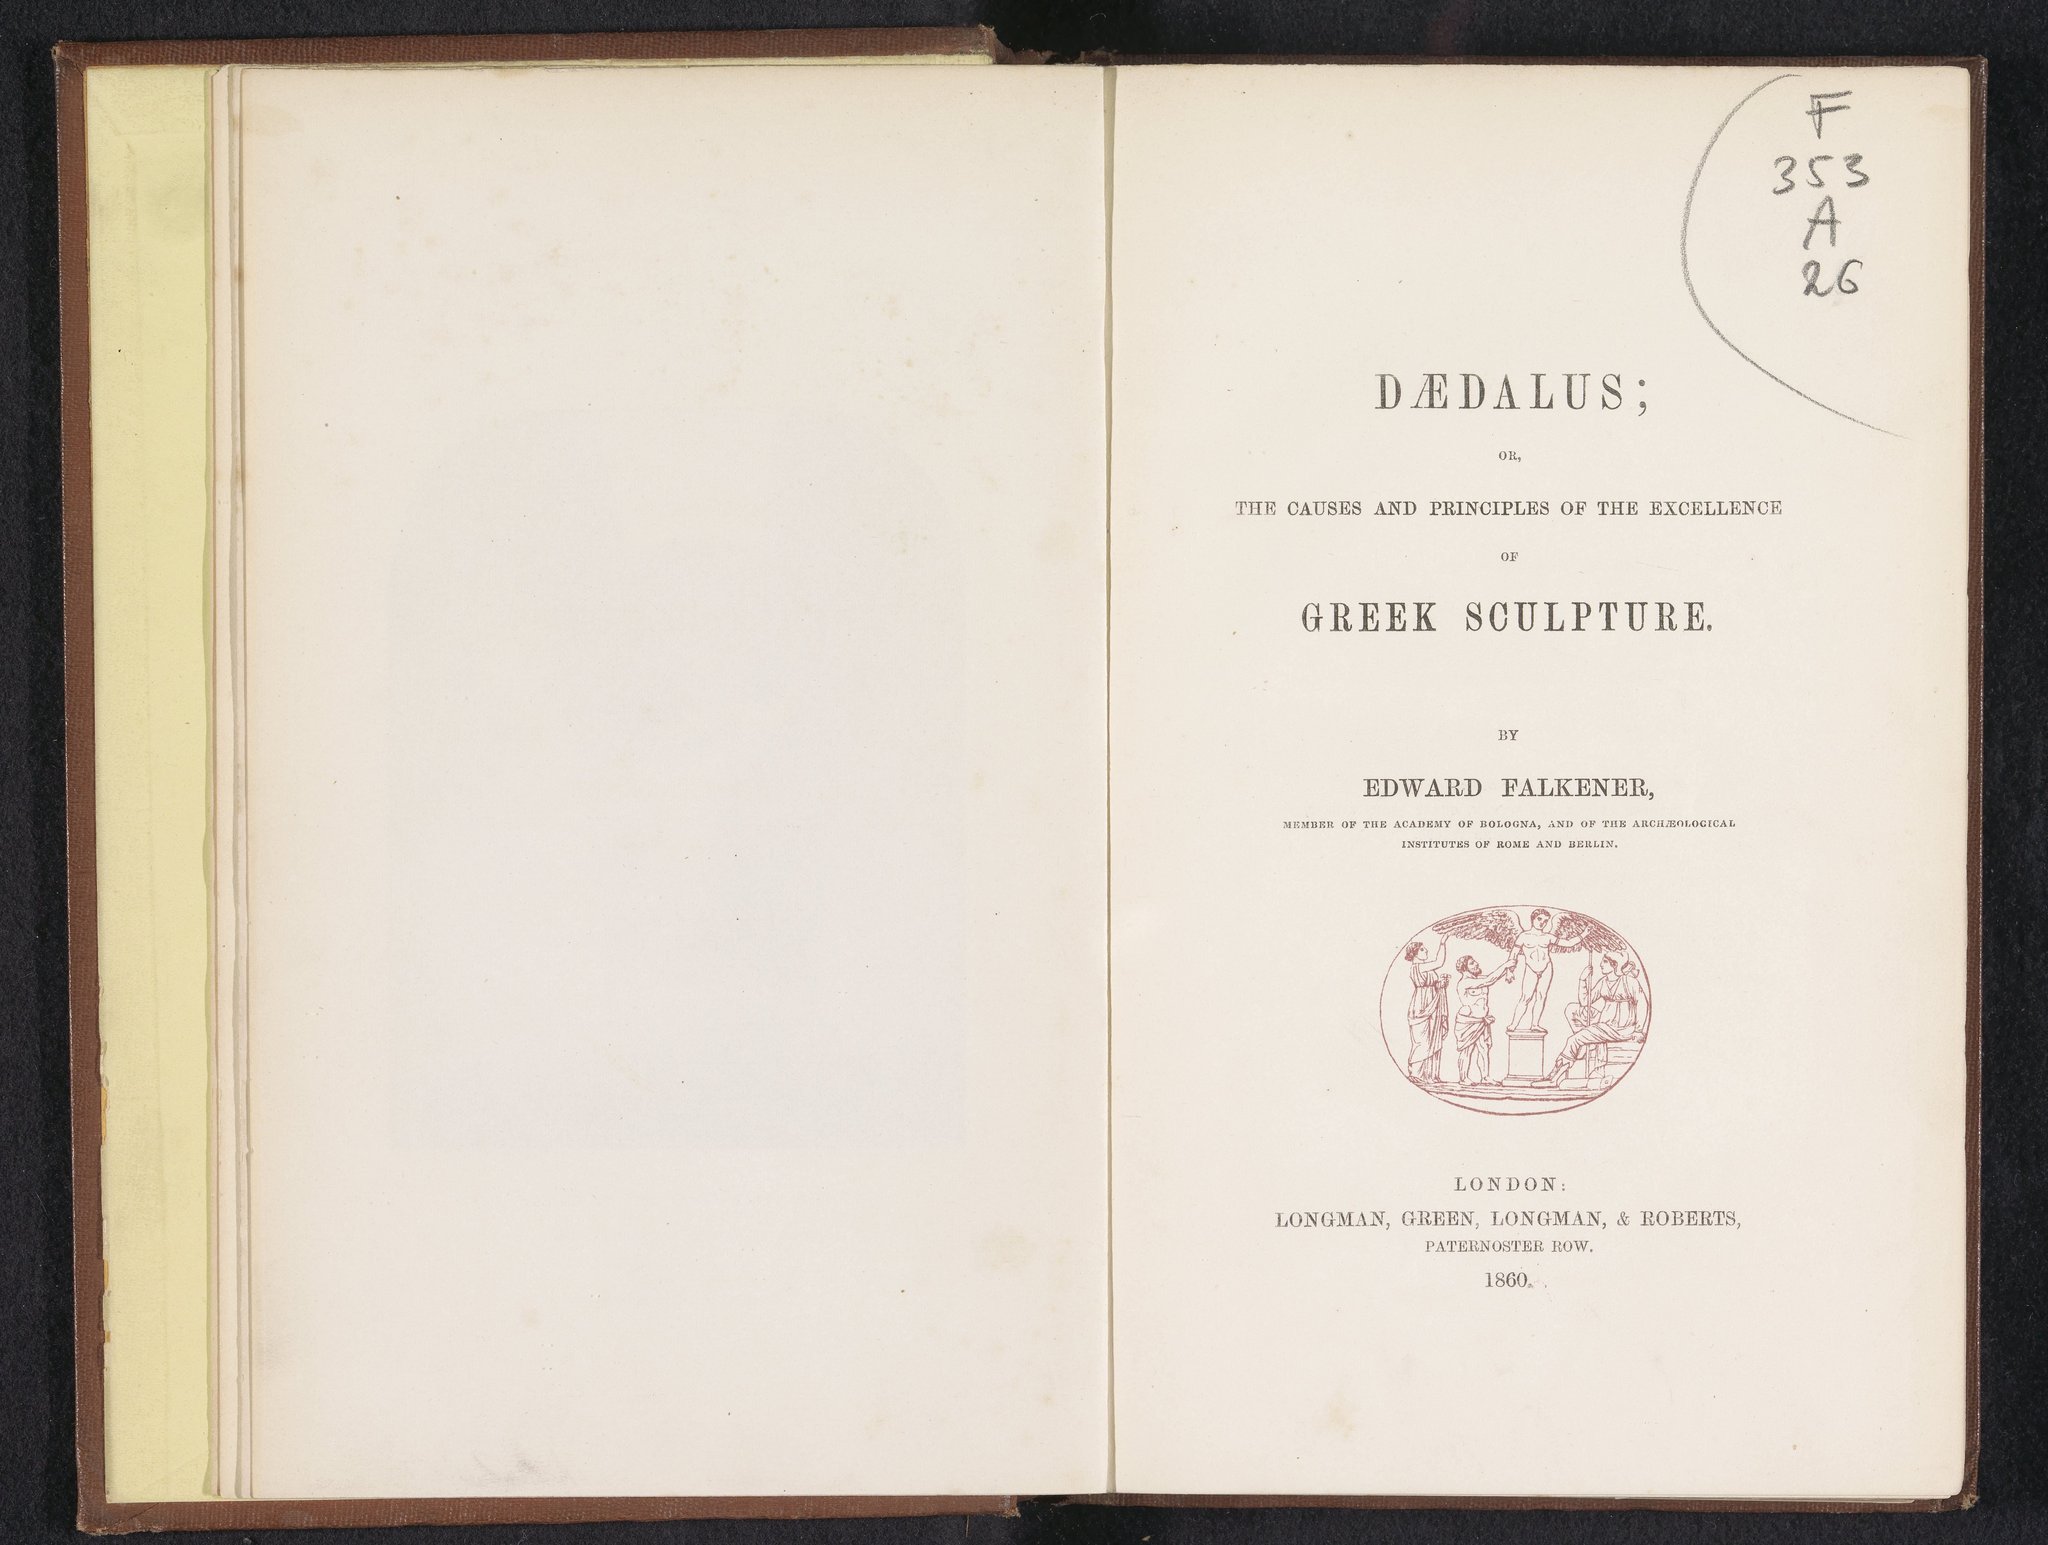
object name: book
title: Daedalus; or, the causes and principles of the excellence of Greek sculpture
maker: edward falkener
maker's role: architect, kunsthistoricus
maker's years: 1814-1896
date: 1860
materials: cardboard, linen, paper, photographic support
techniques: albumen print, etching, lithograph, printing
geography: london